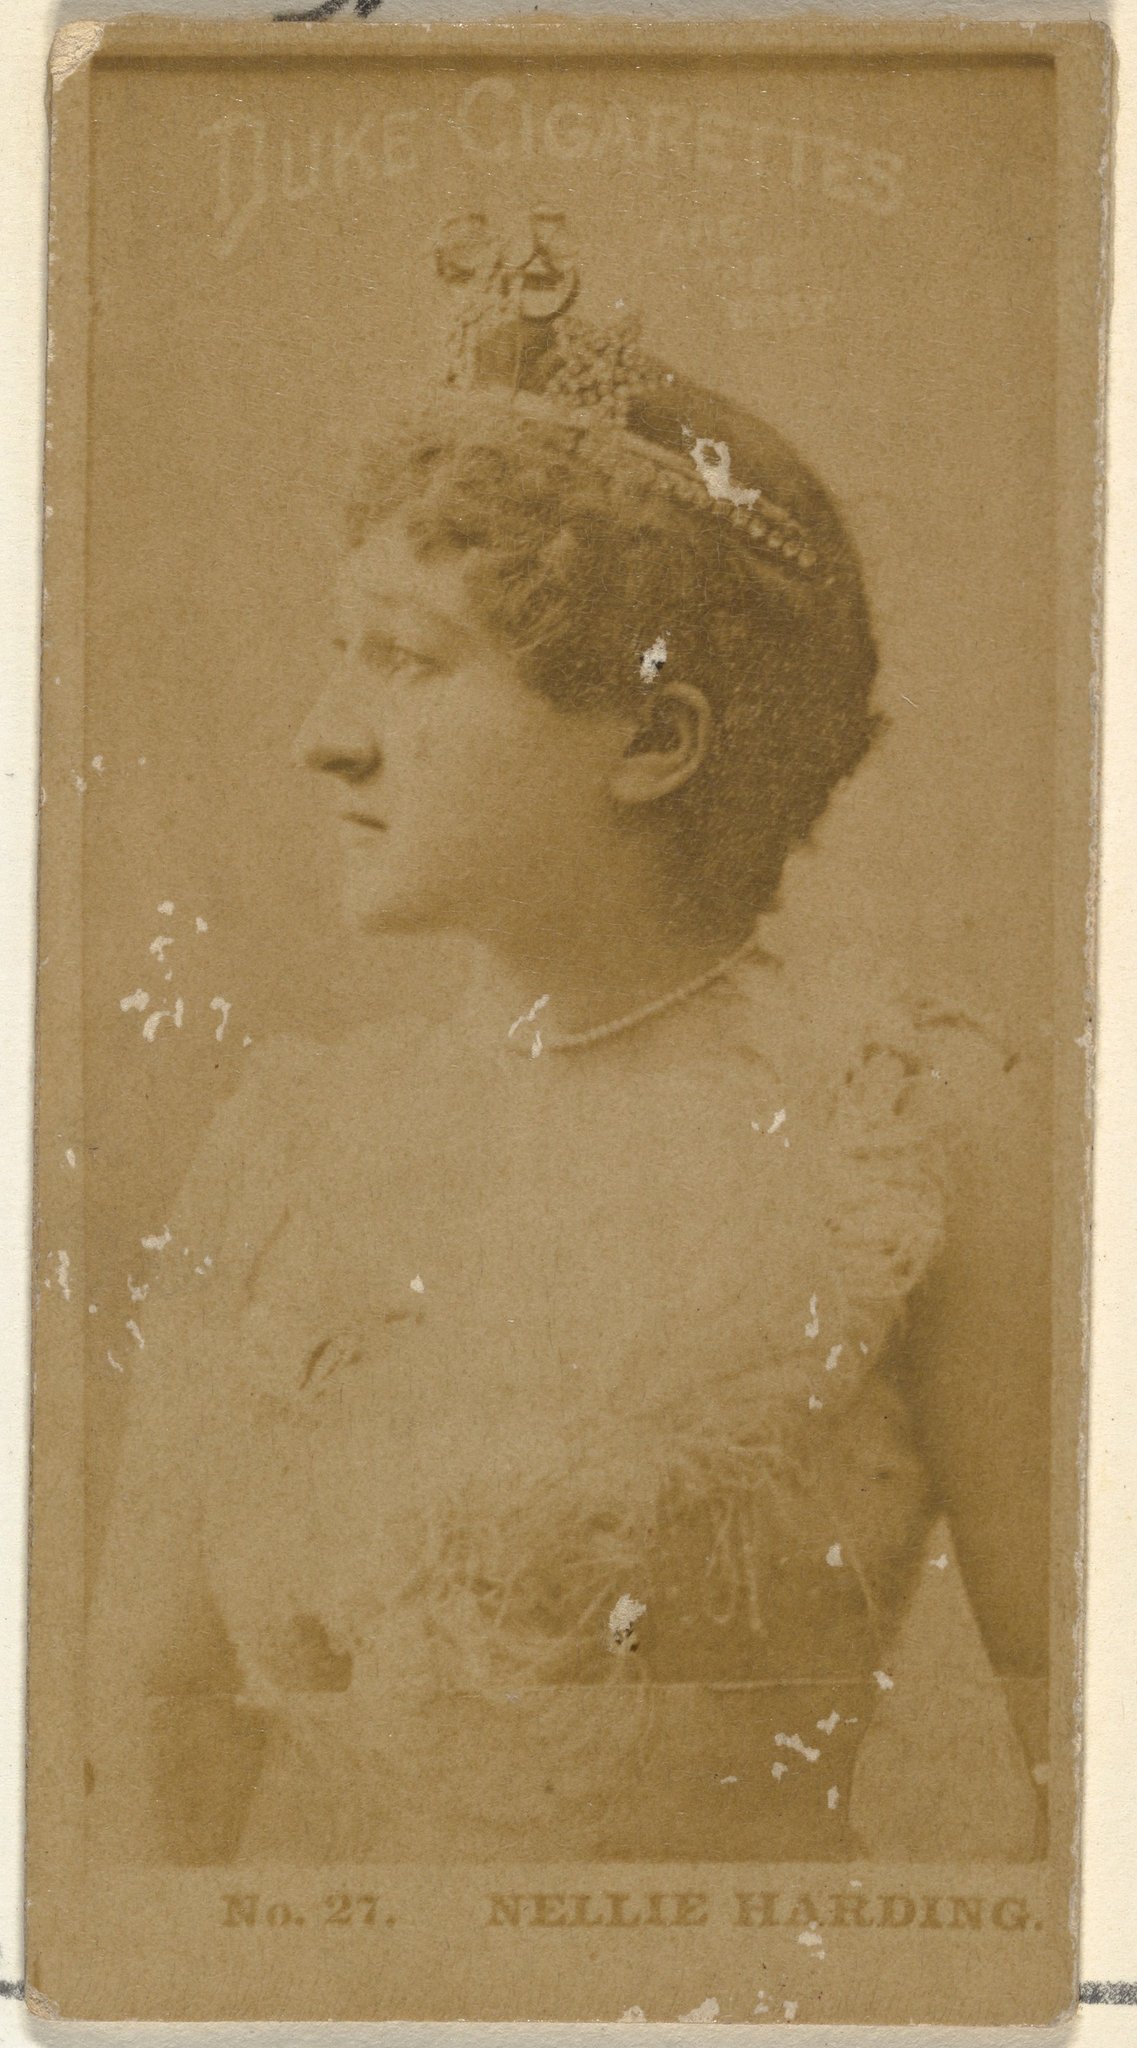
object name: photograph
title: Card Number 27, Nellie Harding, from the Actors and Actresses series (N145-6) issued by Duke Sons & Co. to promote Duke Cigarettes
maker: w. duke, sons & co.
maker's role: publisher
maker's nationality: american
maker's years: 1870-1920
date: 1880-1889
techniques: albumen silver print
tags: women,actresses